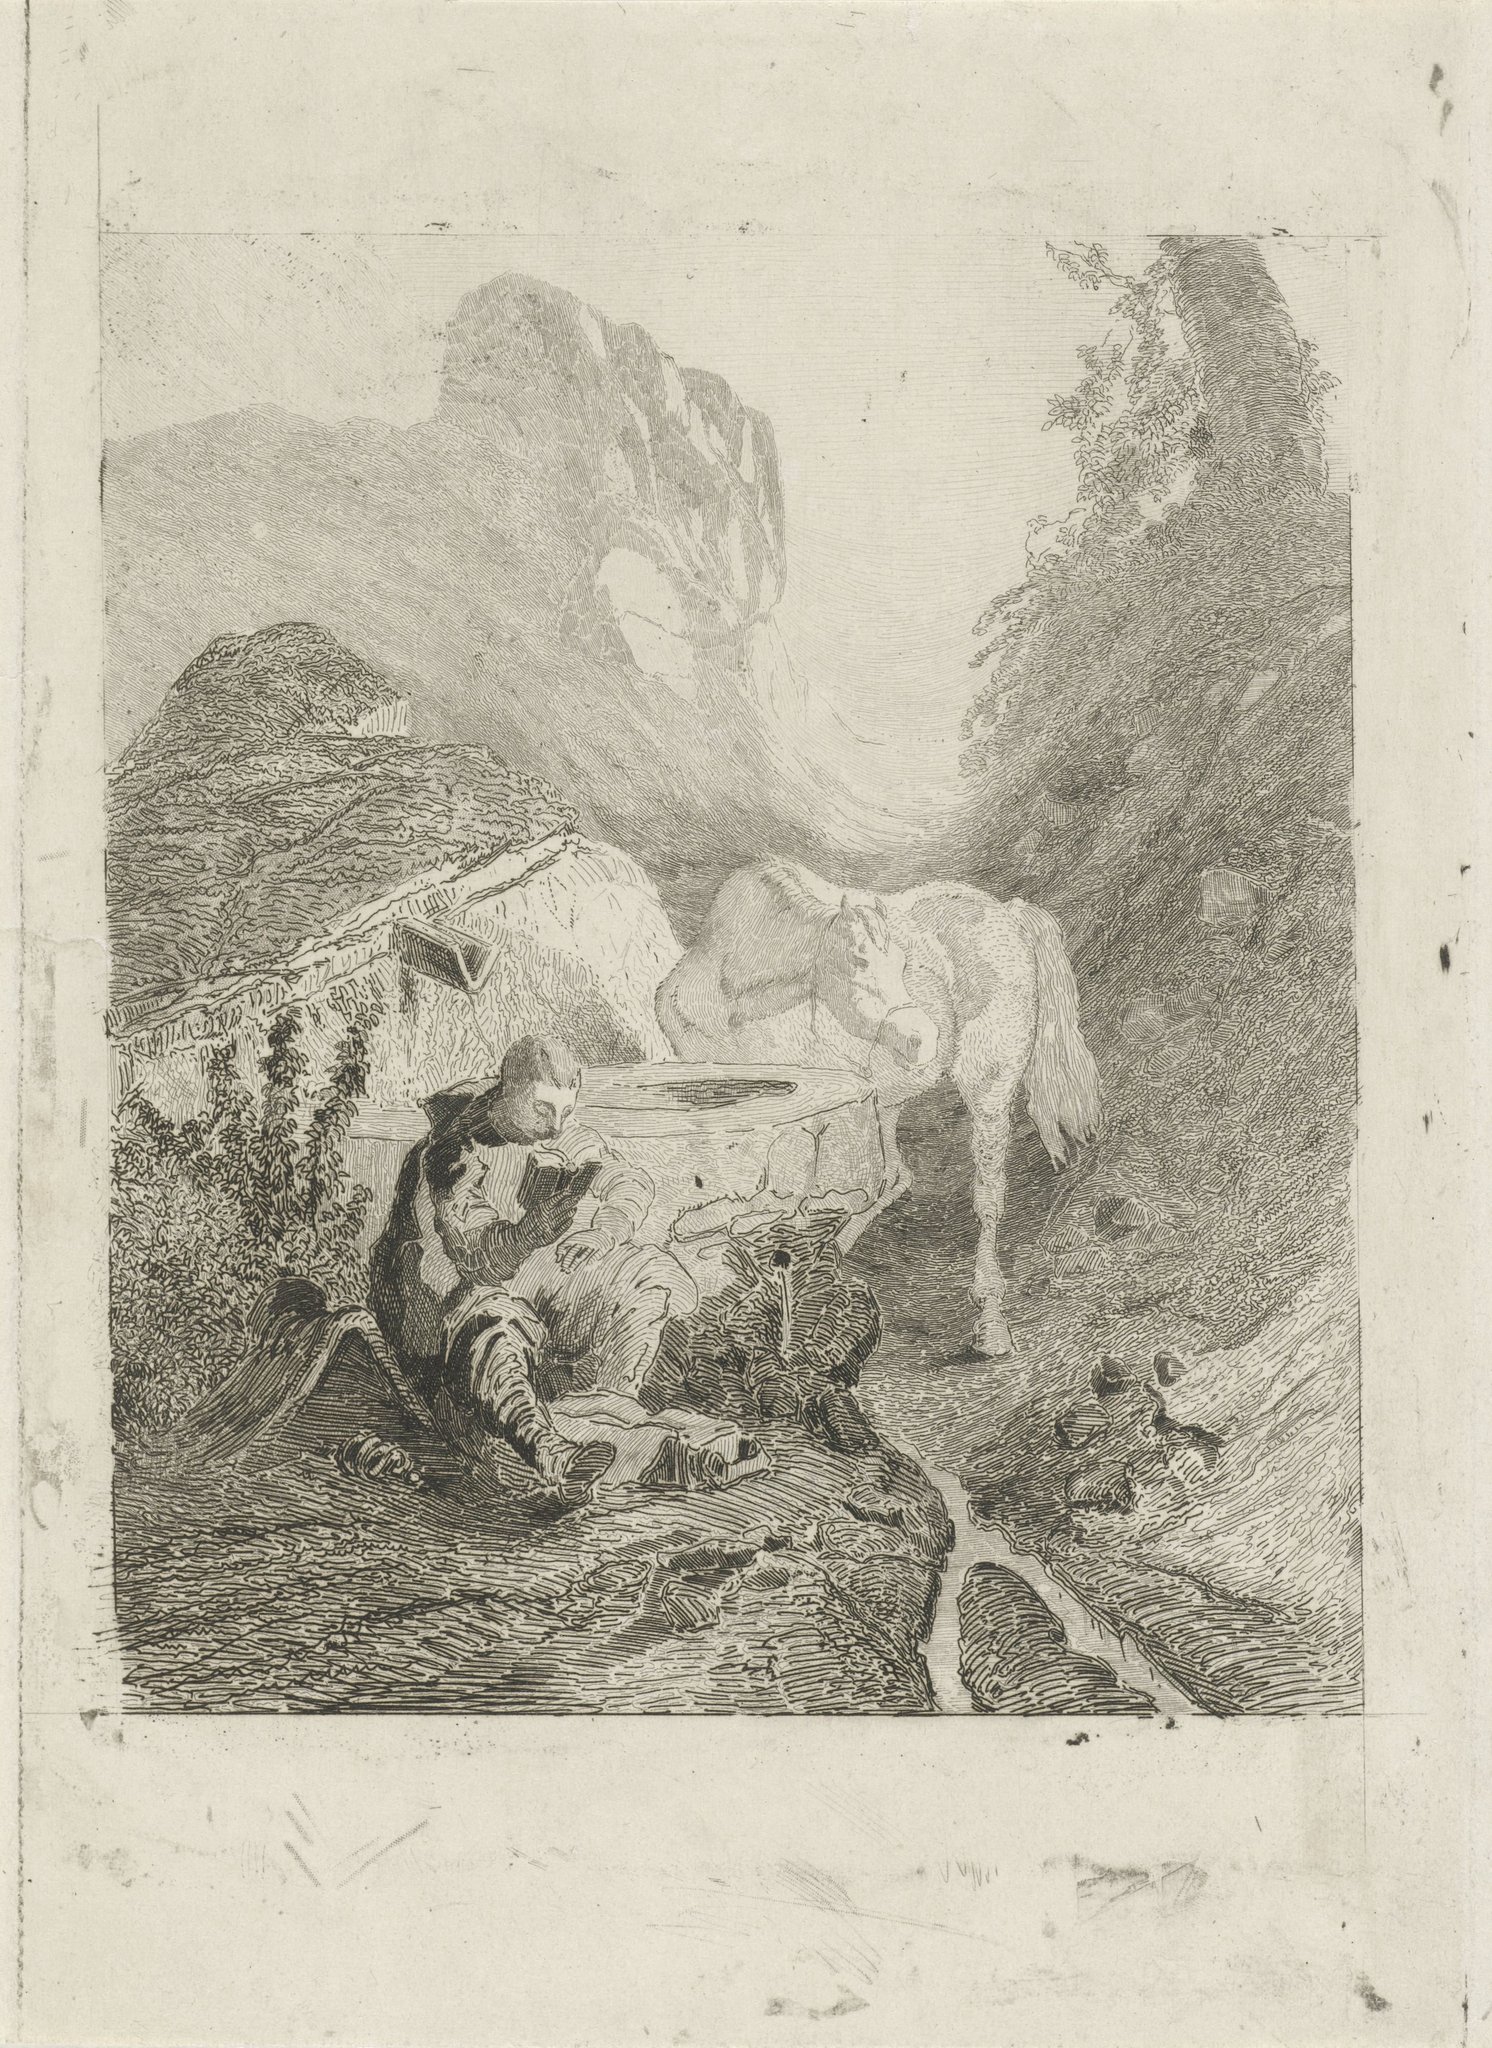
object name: print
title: Lezende man bij een bron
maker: charles rochussen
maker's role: draughtsman, painter, print maker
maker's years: 1814-1894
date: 1824-1894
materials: paper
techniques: etching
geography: netherlands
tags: well, reading, saddle, horse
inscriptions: collector's mark: Lugt 2228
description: In een heuvelachtig landschap zit een man te lezen bij een bron. Achter de bron staat zijn afgezadelde paard. Het zadel ligt naast hem.